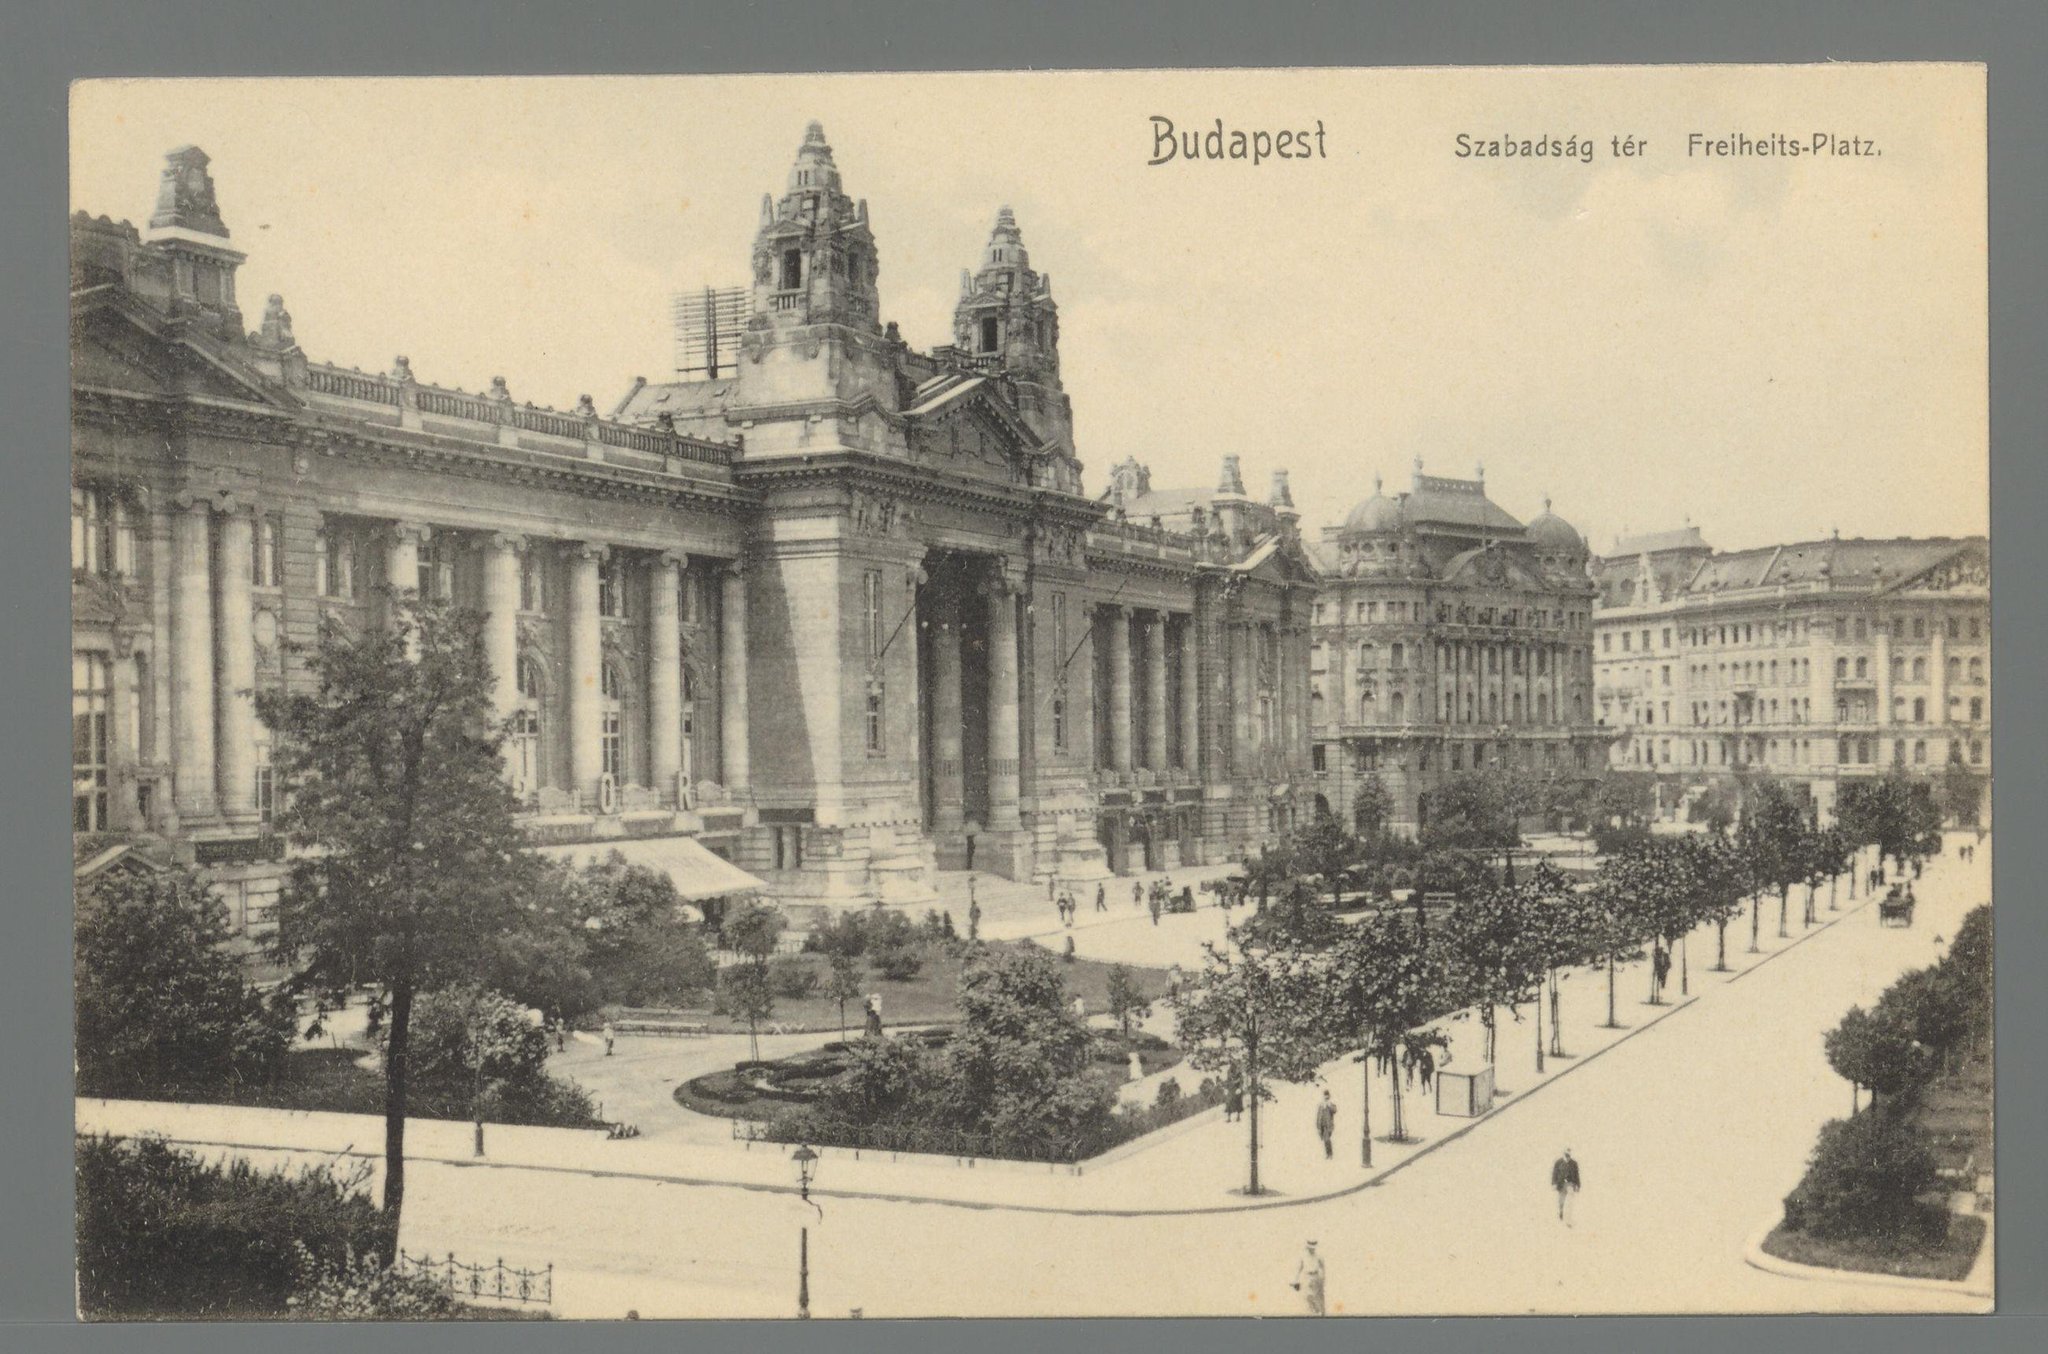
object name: ansichtkaart, prentbriefkaart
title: Budapest. Szabadság tér / Freiheits-Platz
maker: Anonymous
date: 1905-1930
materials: cardboard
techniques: photograph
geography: budapest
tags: square, place, circus, etc.